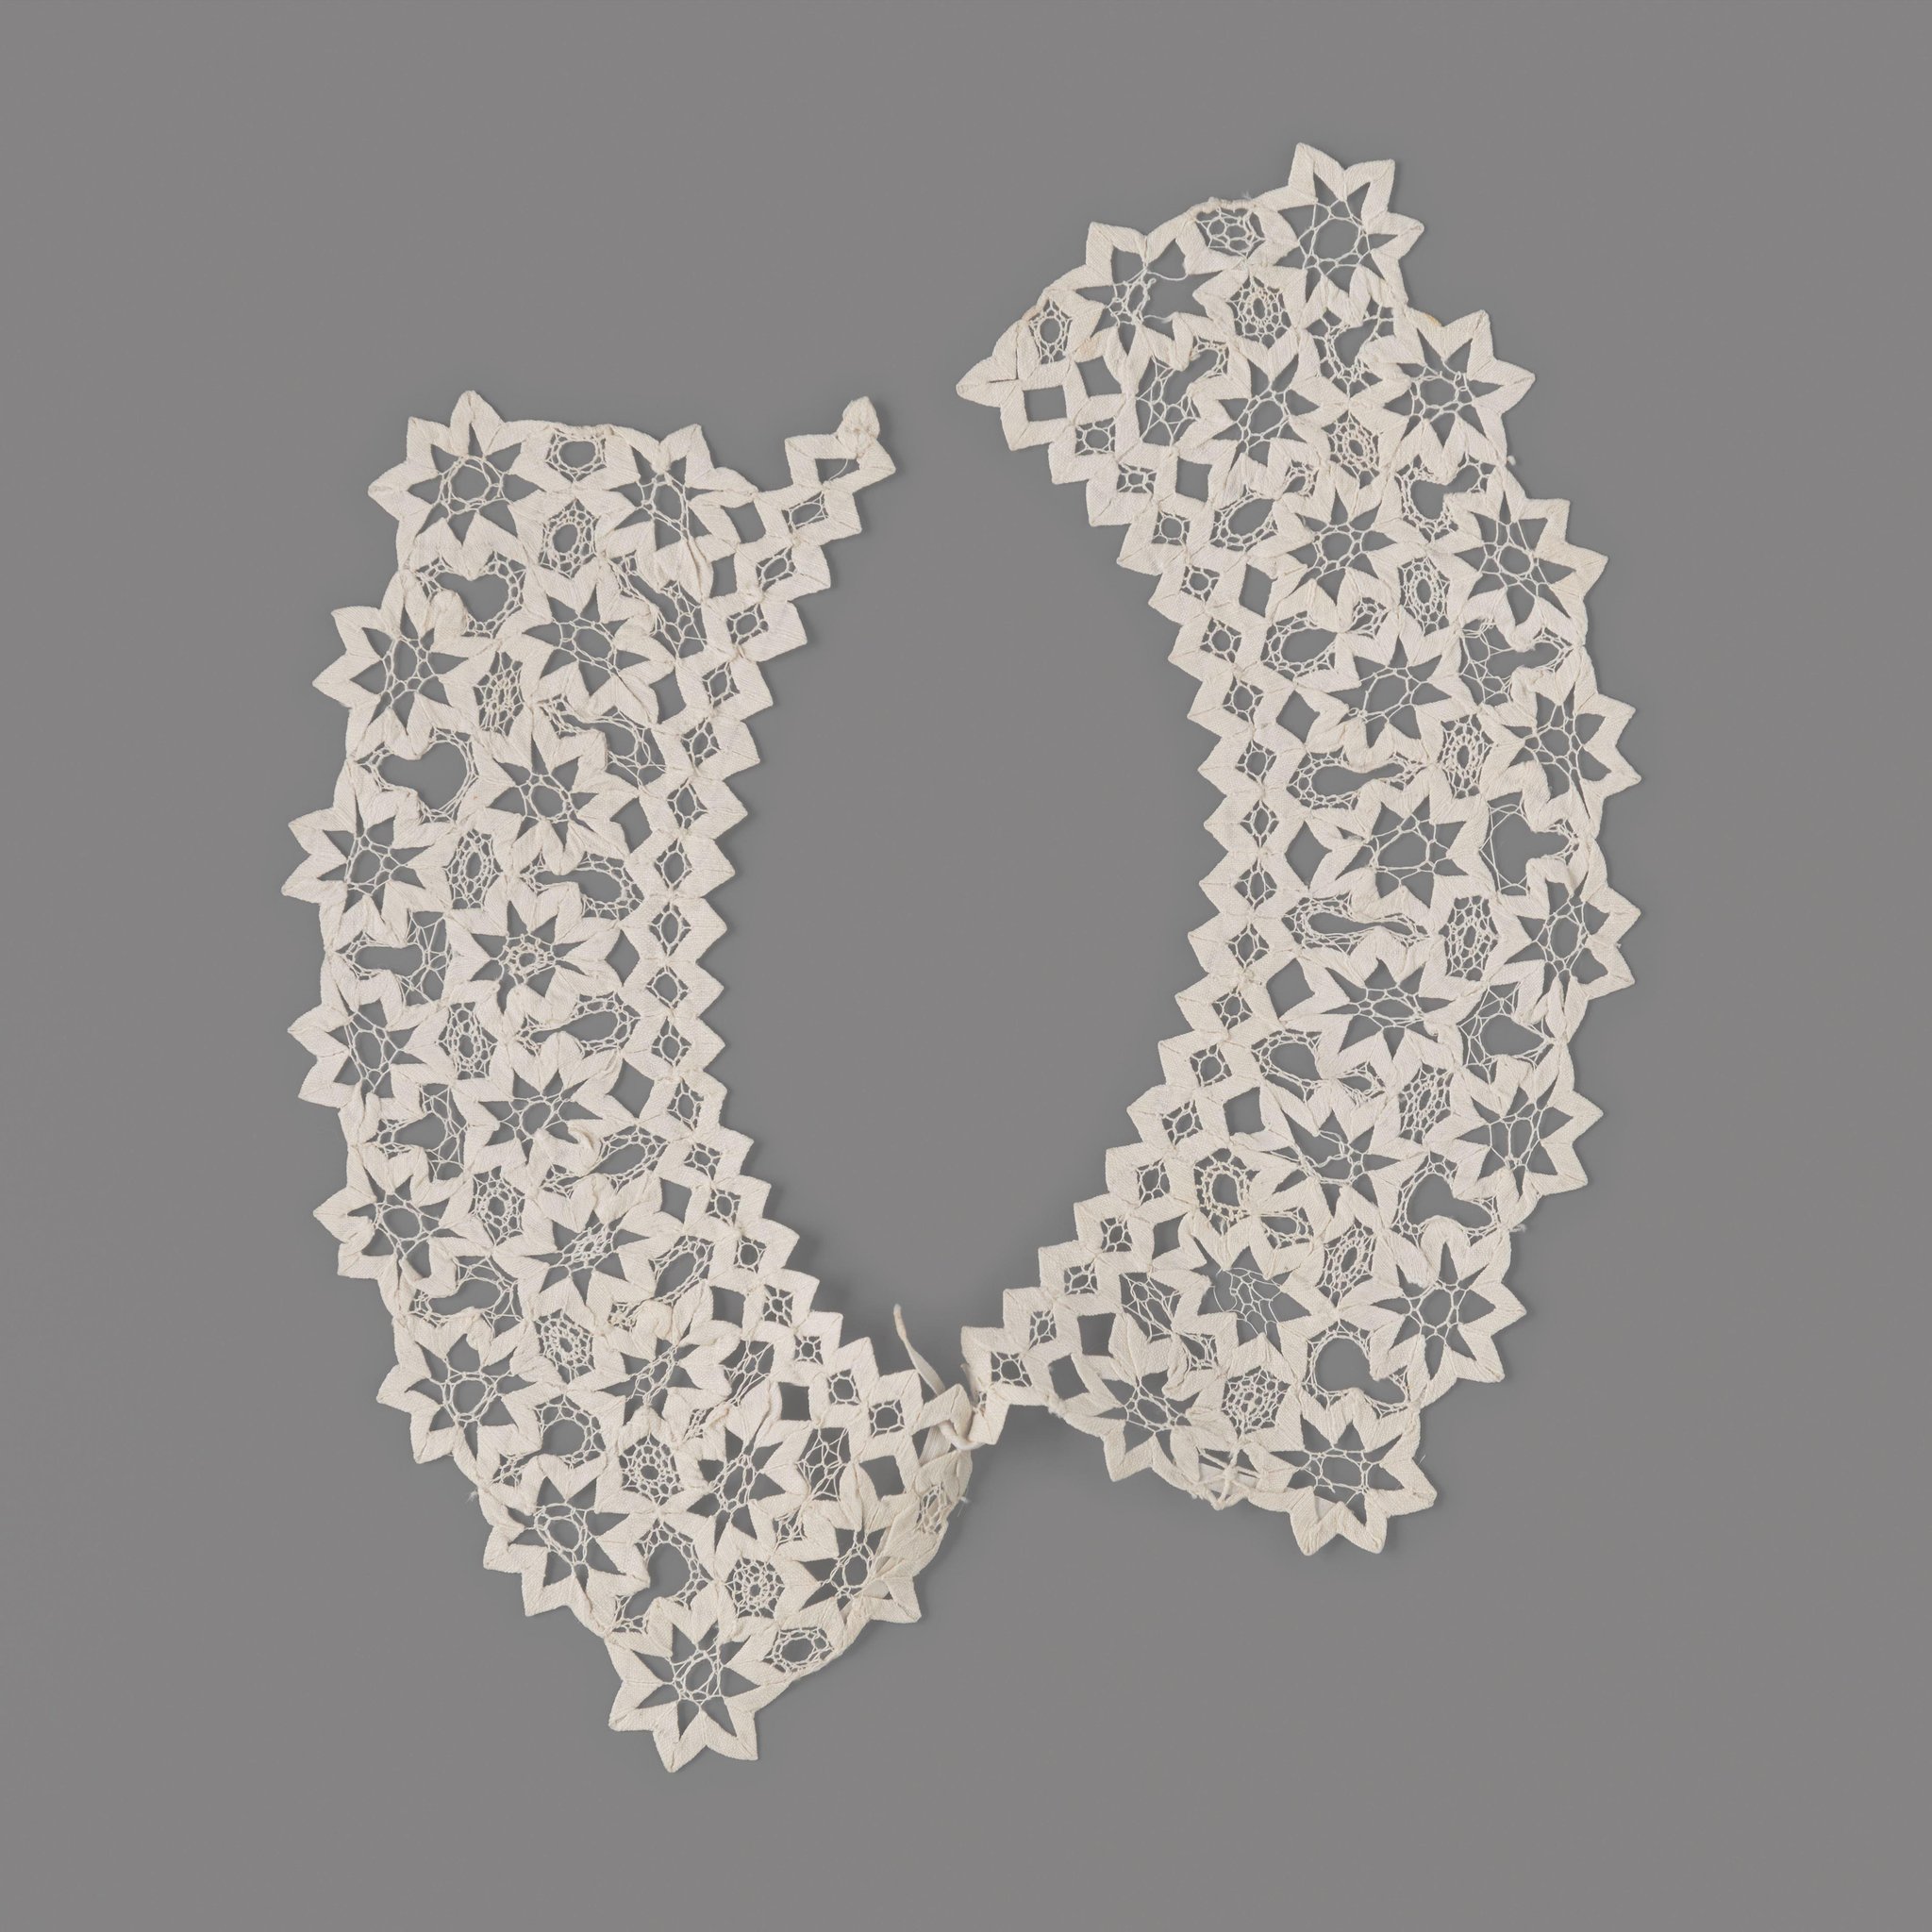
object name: clothing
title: Manchet van lintjeskant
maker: Anonymous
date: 1800-1899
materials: linen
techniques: lace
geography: western europe